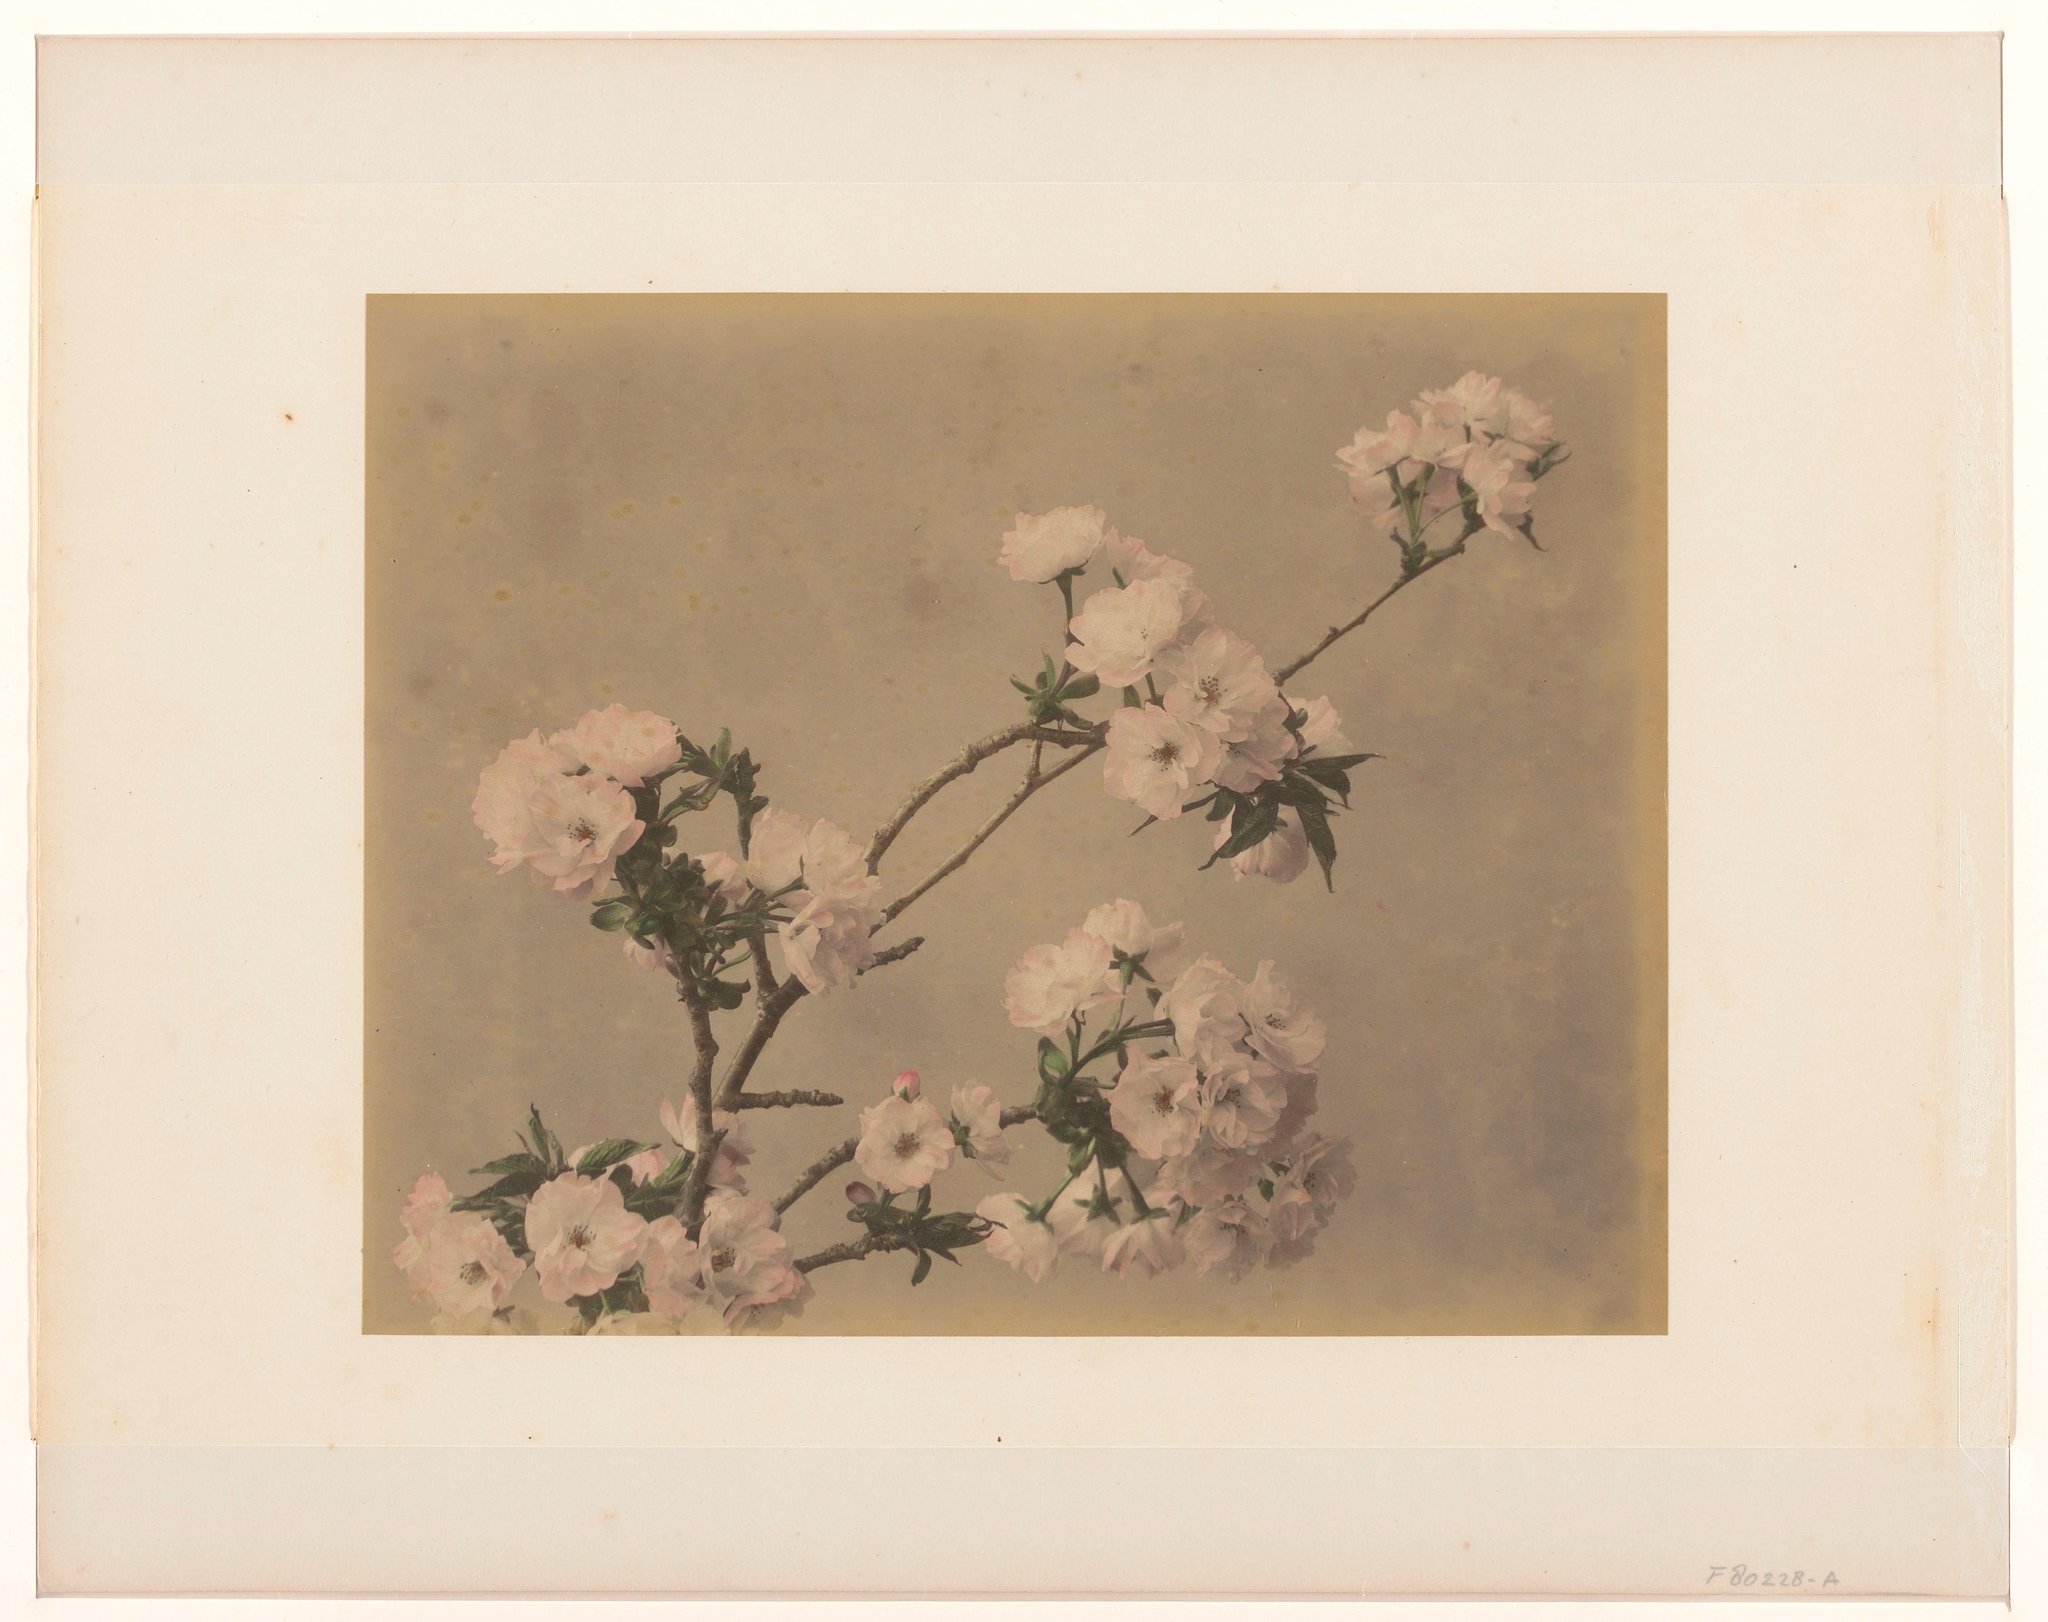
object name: photograph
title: Pioenrozen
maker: Anonymous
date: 1855-1890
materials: cardboard, paper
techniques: albumen print, hand coloring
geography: japan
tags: flowers, japan